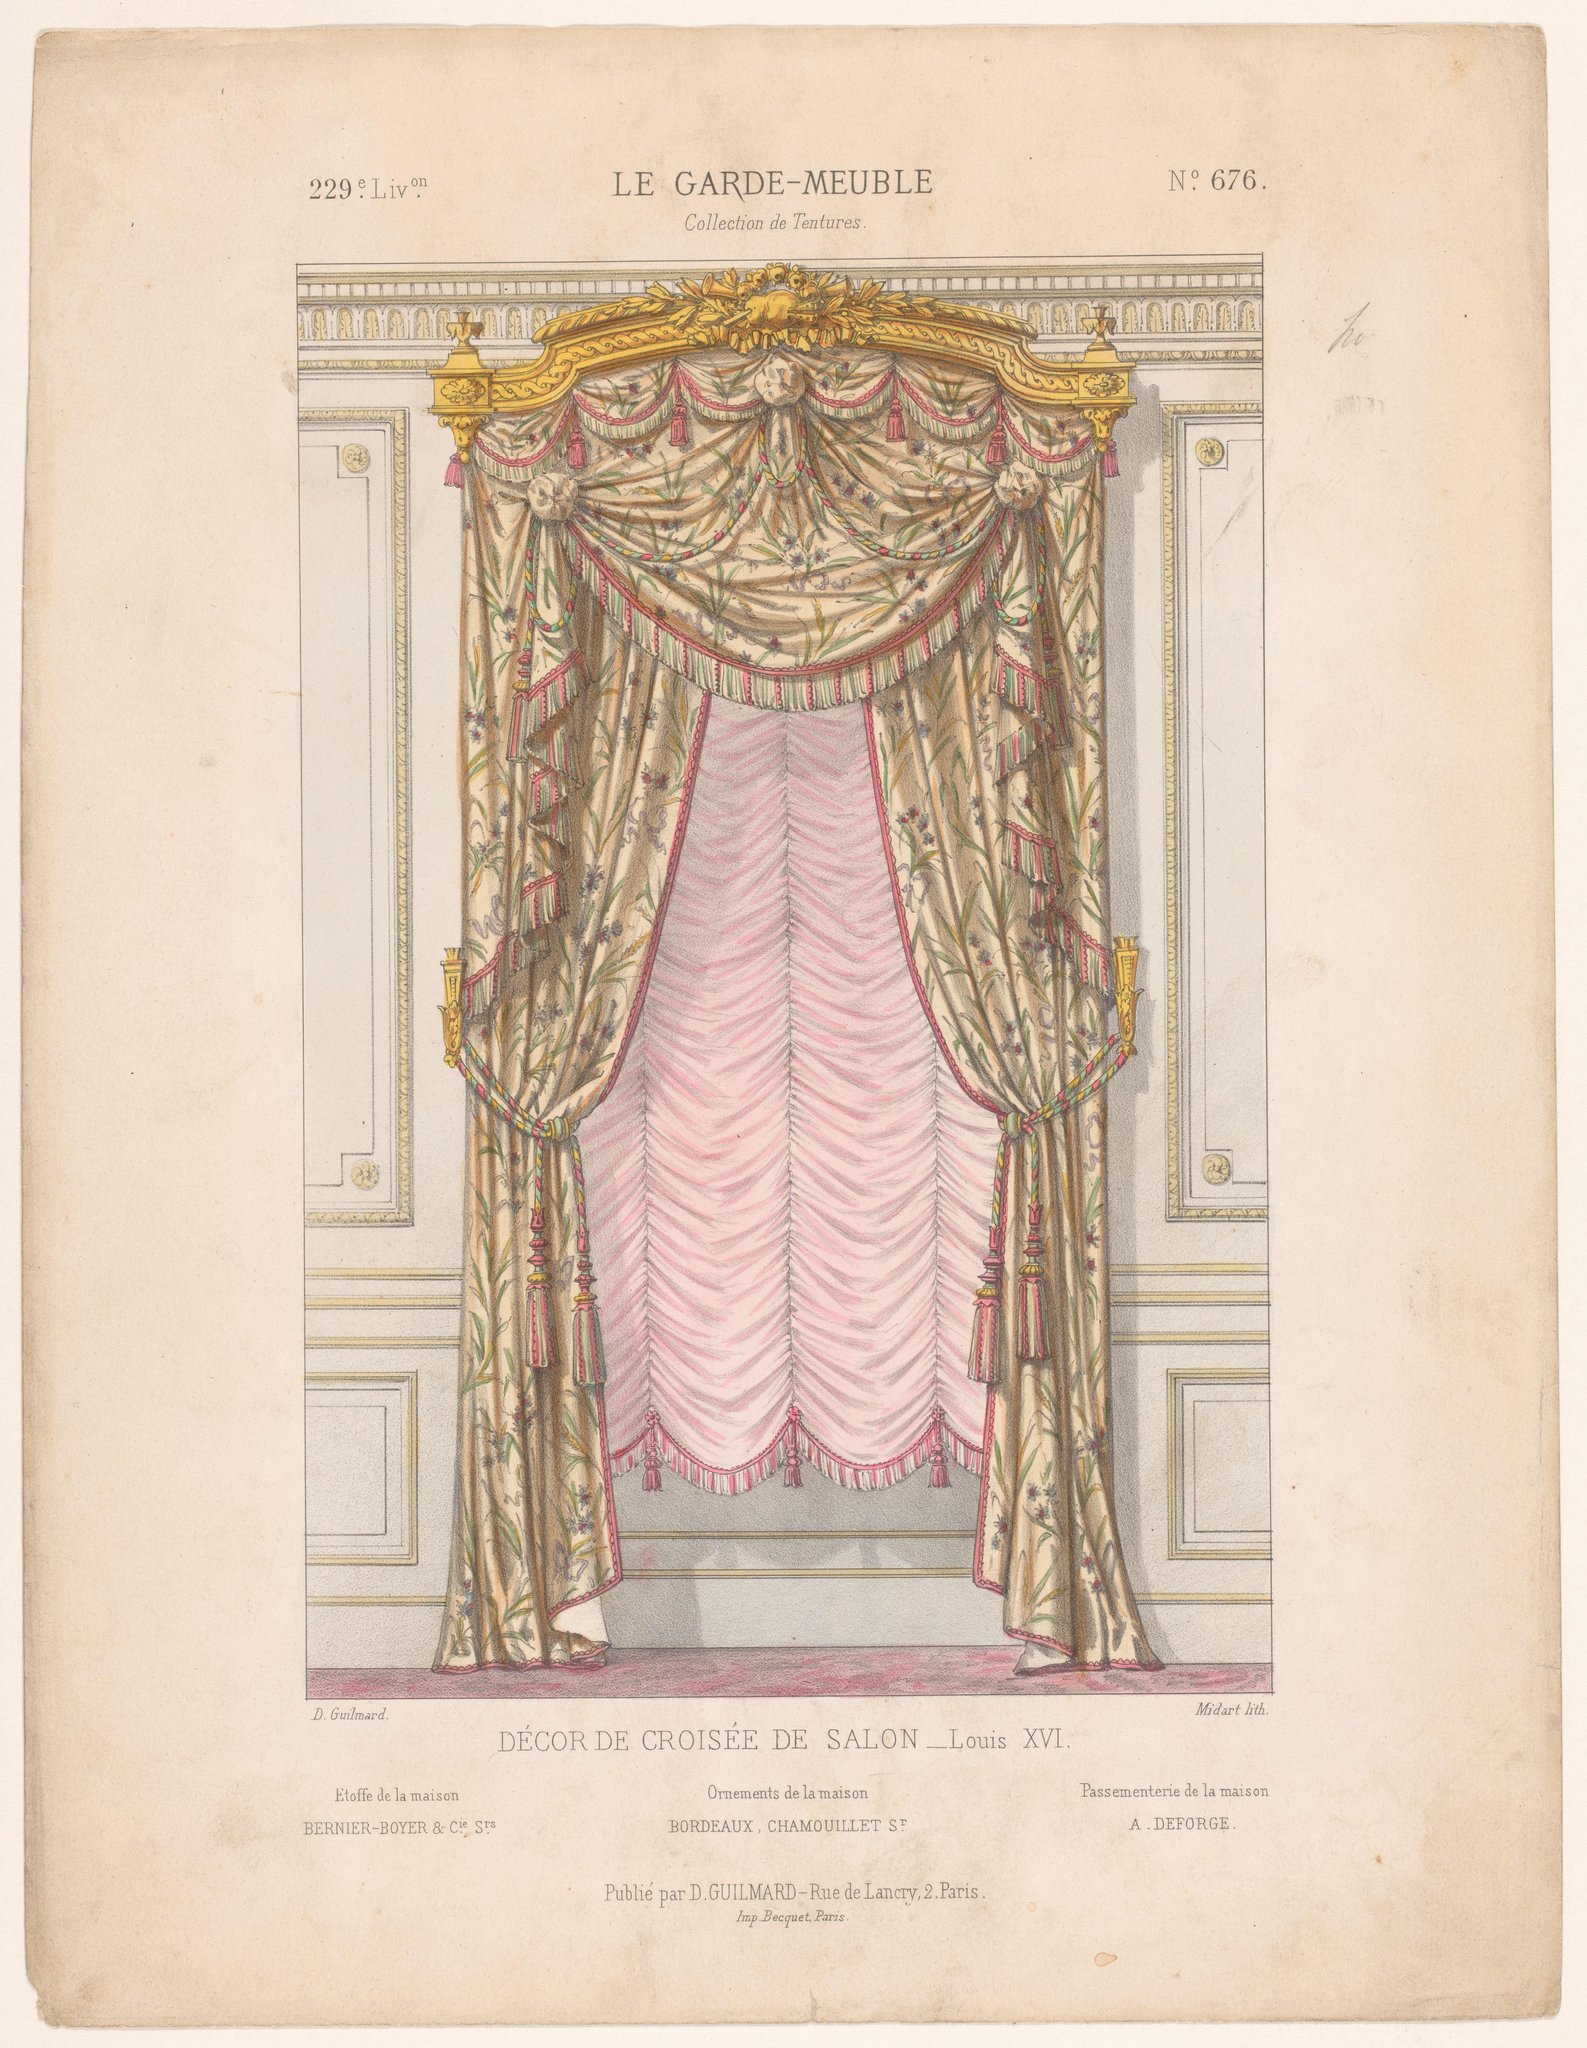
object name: print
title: Venster met gordijnen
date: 1860-1880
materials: paper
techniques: hand coloring, lithograph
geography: paris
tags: window, hangings and drapery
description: Salonvenster met gedrapeerde gordijnen in de Lodewijk XVI-stijl. Prent uit 229e Livraison.